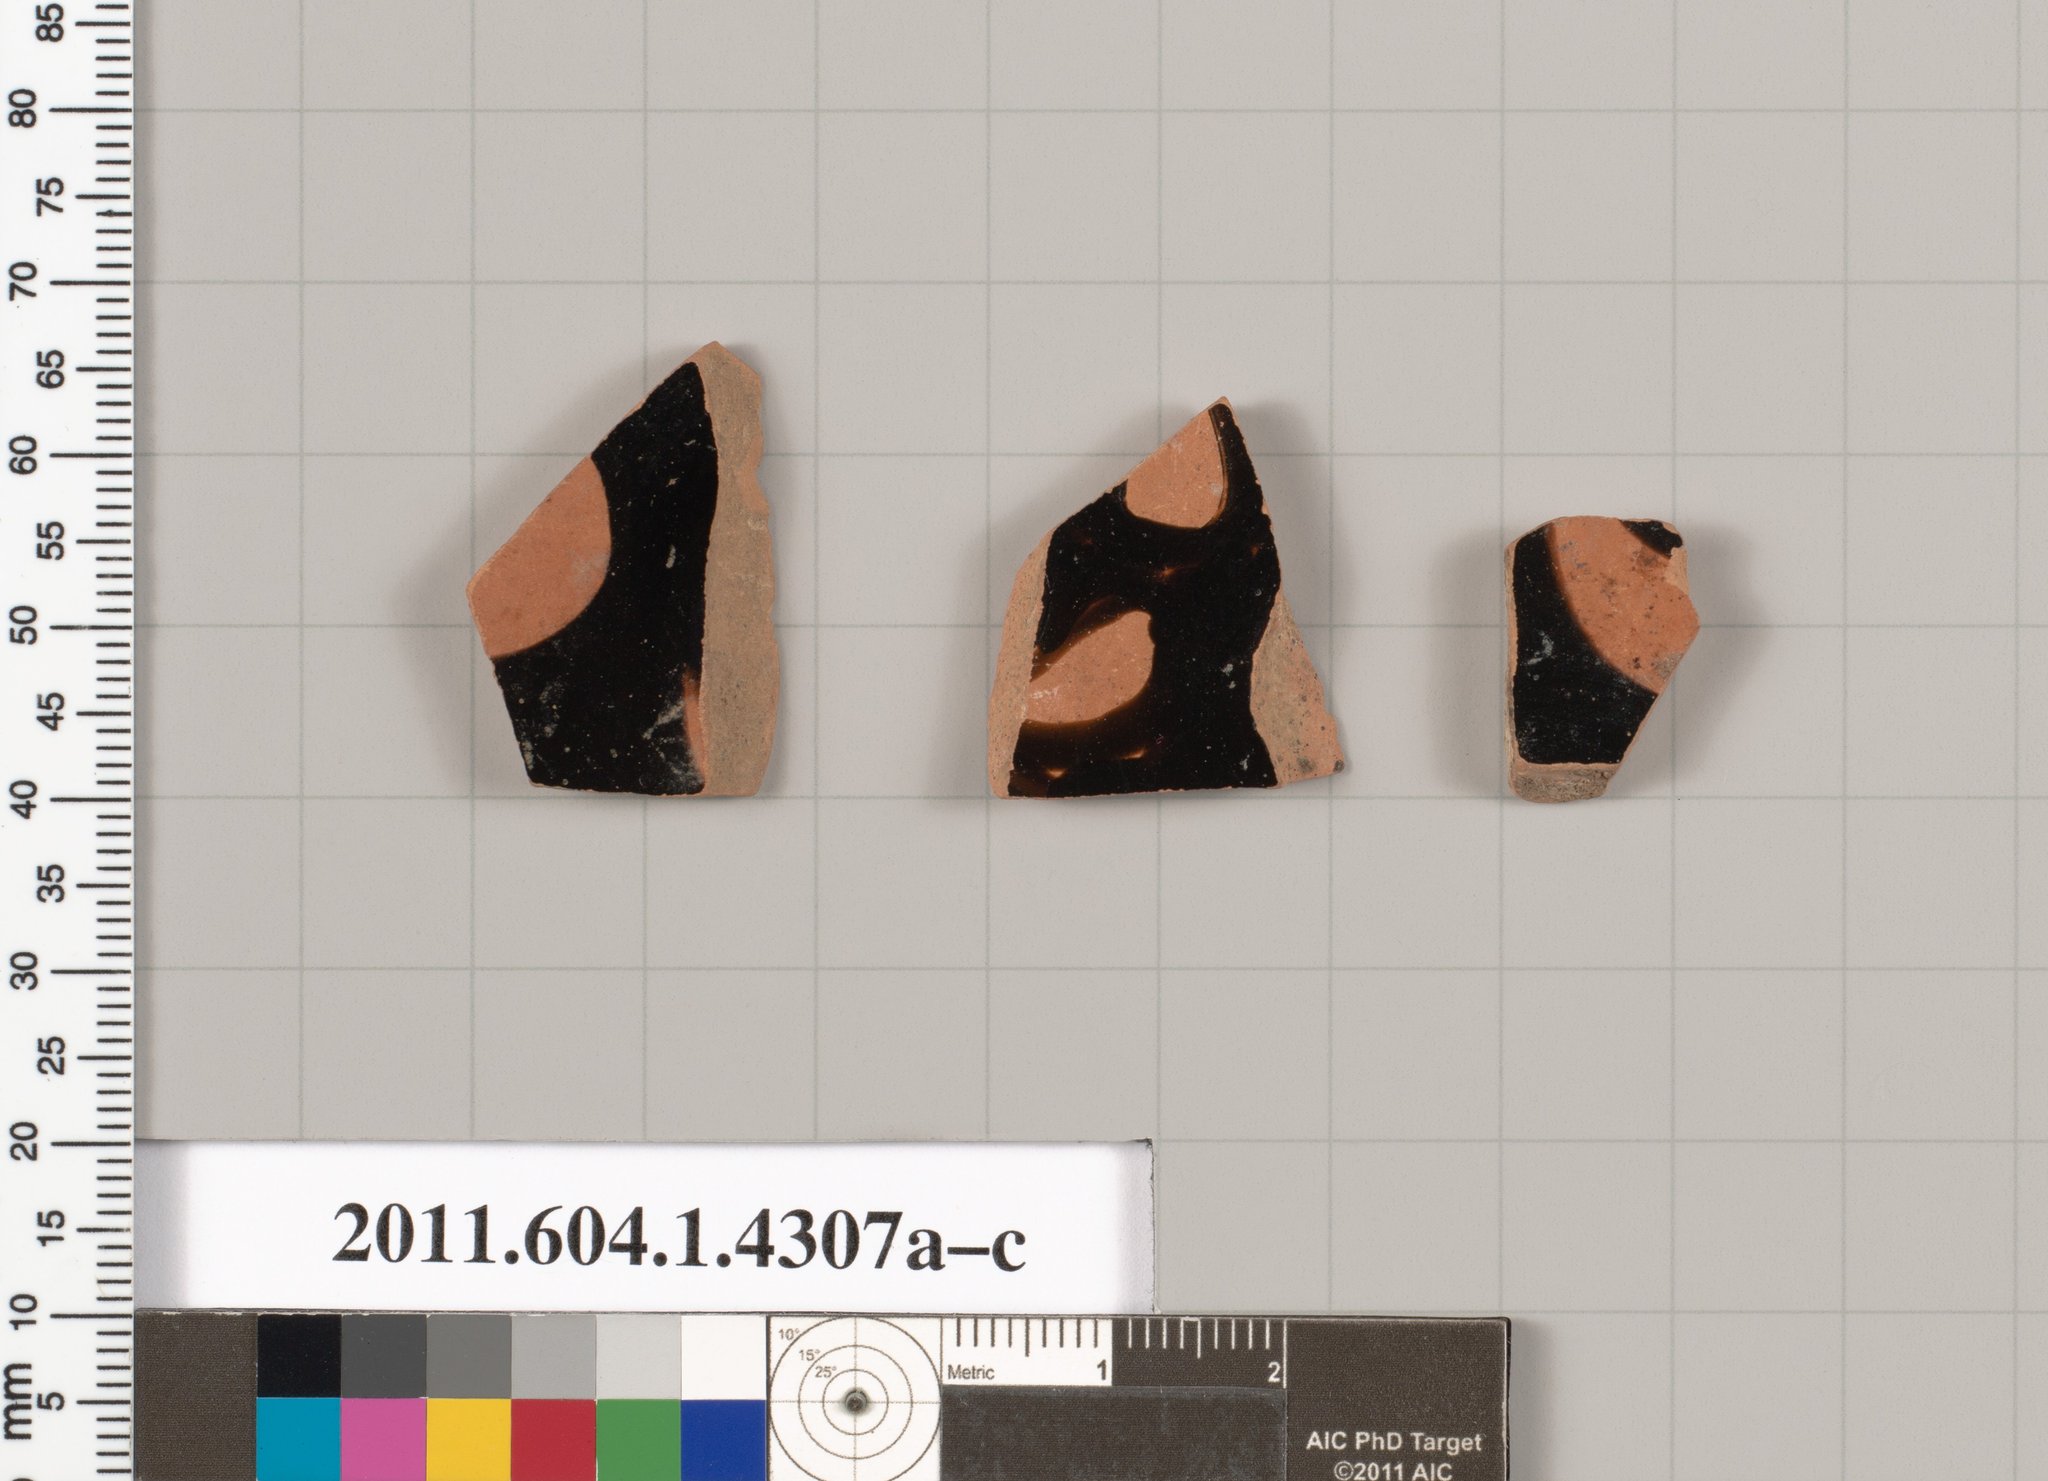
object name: kylix fragment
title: Terracotta fragments of kylikes (drinking cups)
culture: greek, attic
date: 500-451 BCE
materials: terracotta